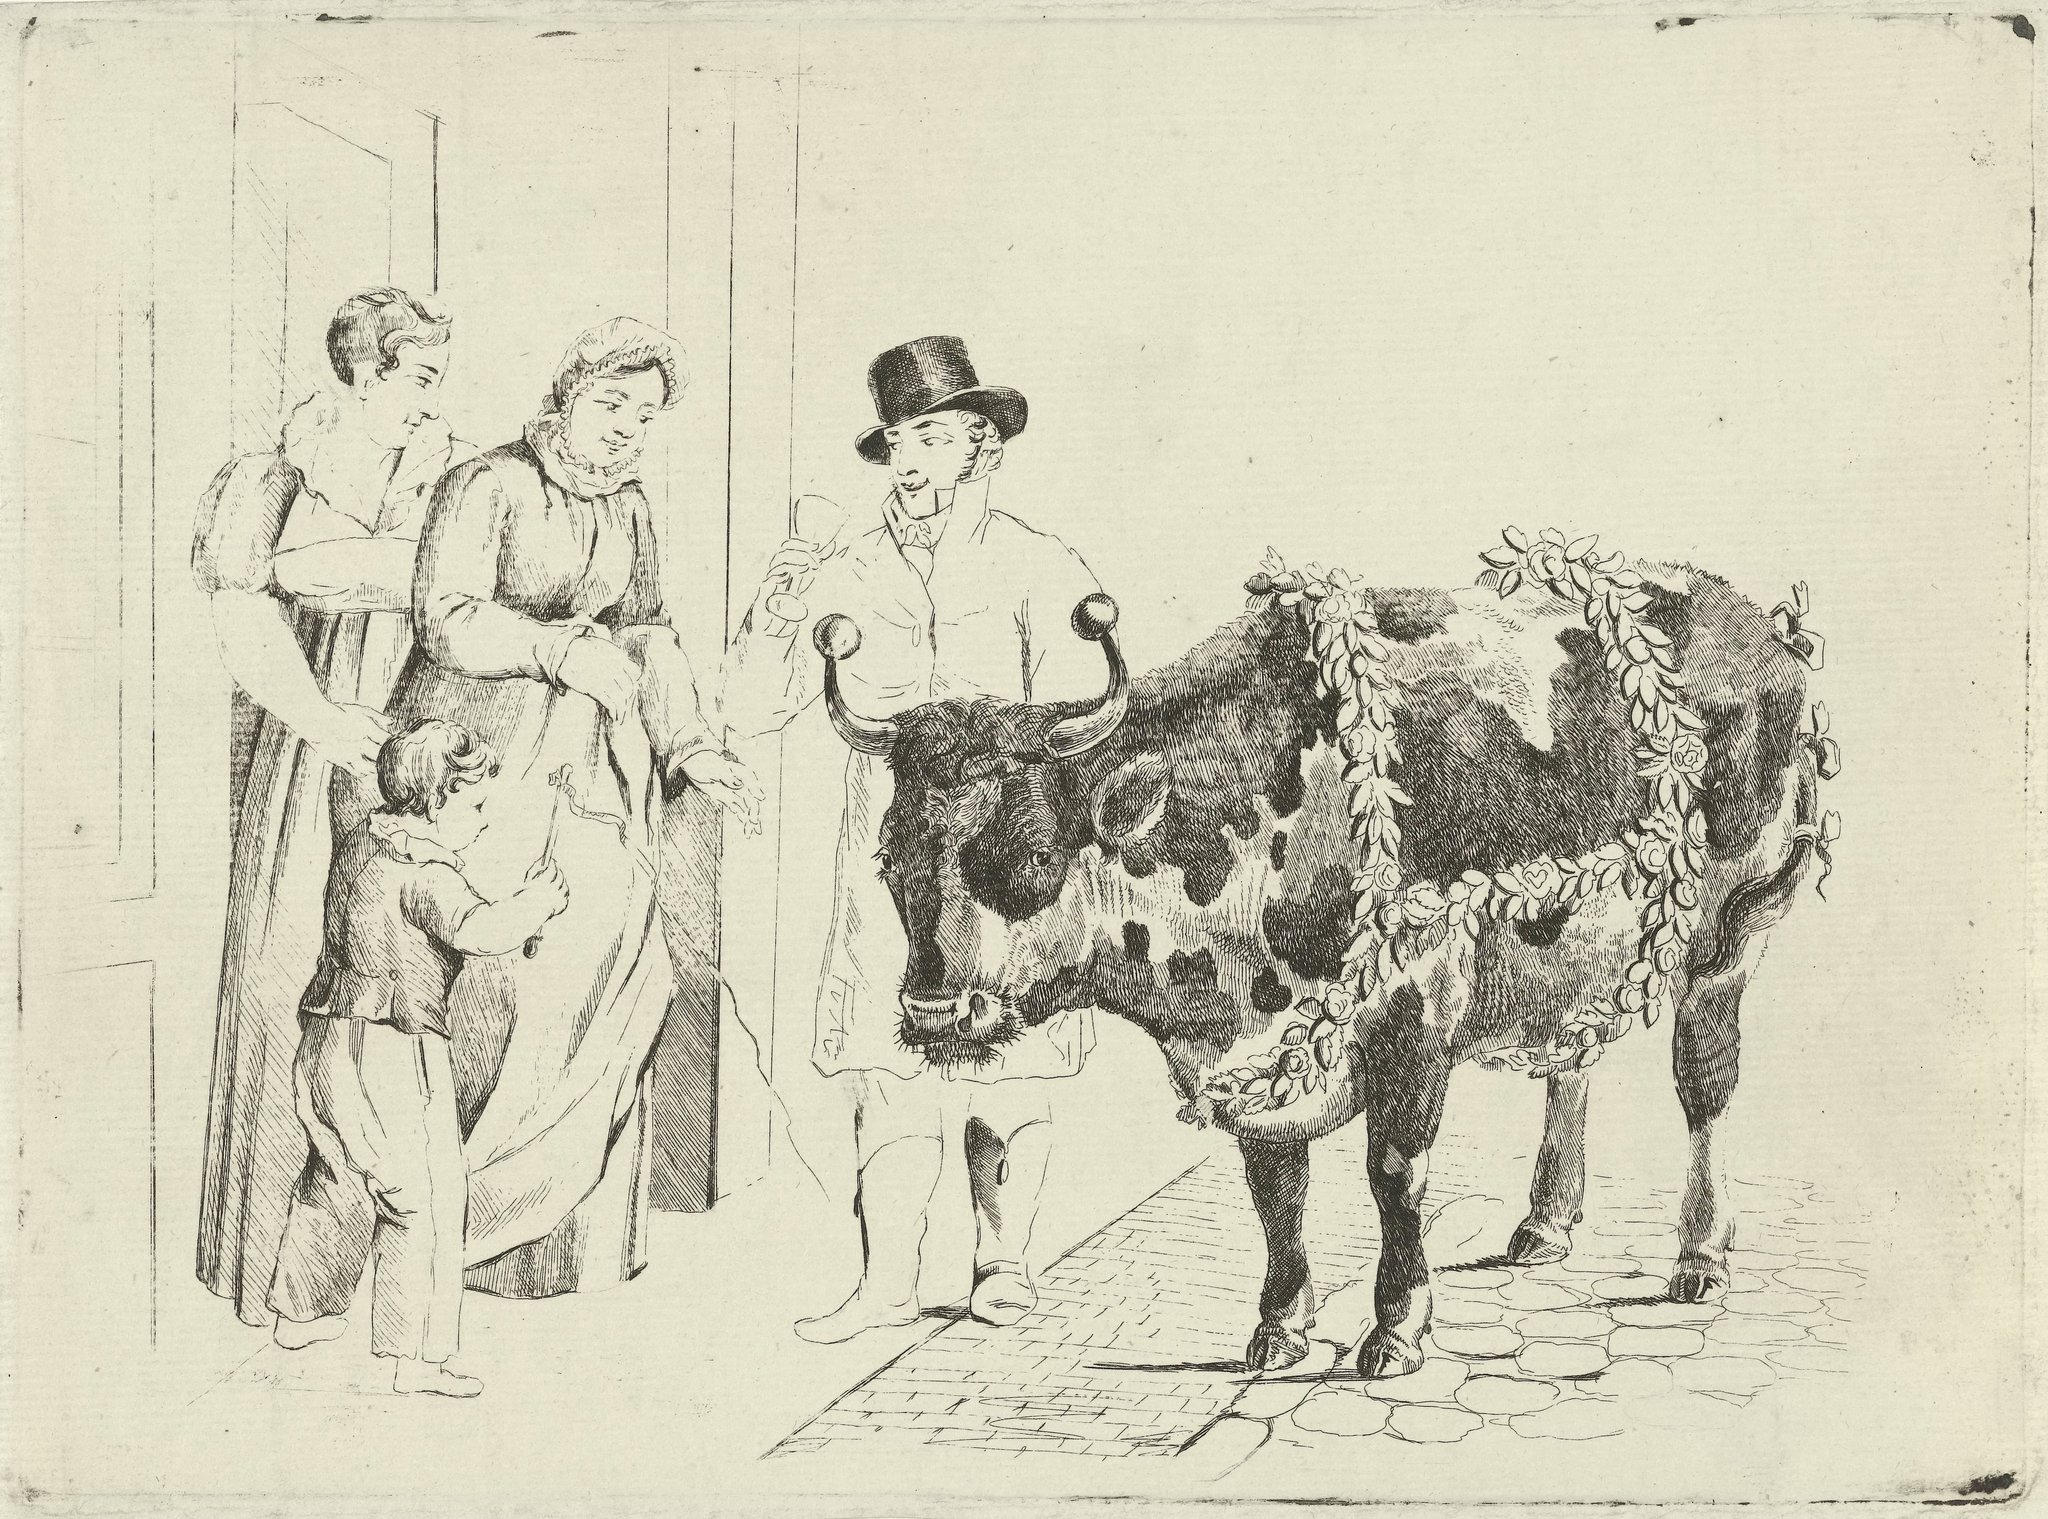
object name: print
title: Versierde koe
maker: anna kobell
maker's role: print maker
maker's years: 1790-1847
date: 1805-1847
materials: paper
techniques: etching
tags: cow, child, glass of wine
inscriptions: collector's mark: Lugt 2228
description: In de deuropening staan twee vrouwen en een kind te kijken naar een man die met een versierde koe op straat staat. De koe heeft ballen op haar horens, strikken om haar staart en een tuig van bloemen om. De man draagt een hoge hoed en heeft een wijnglas in zijn rechterhand.